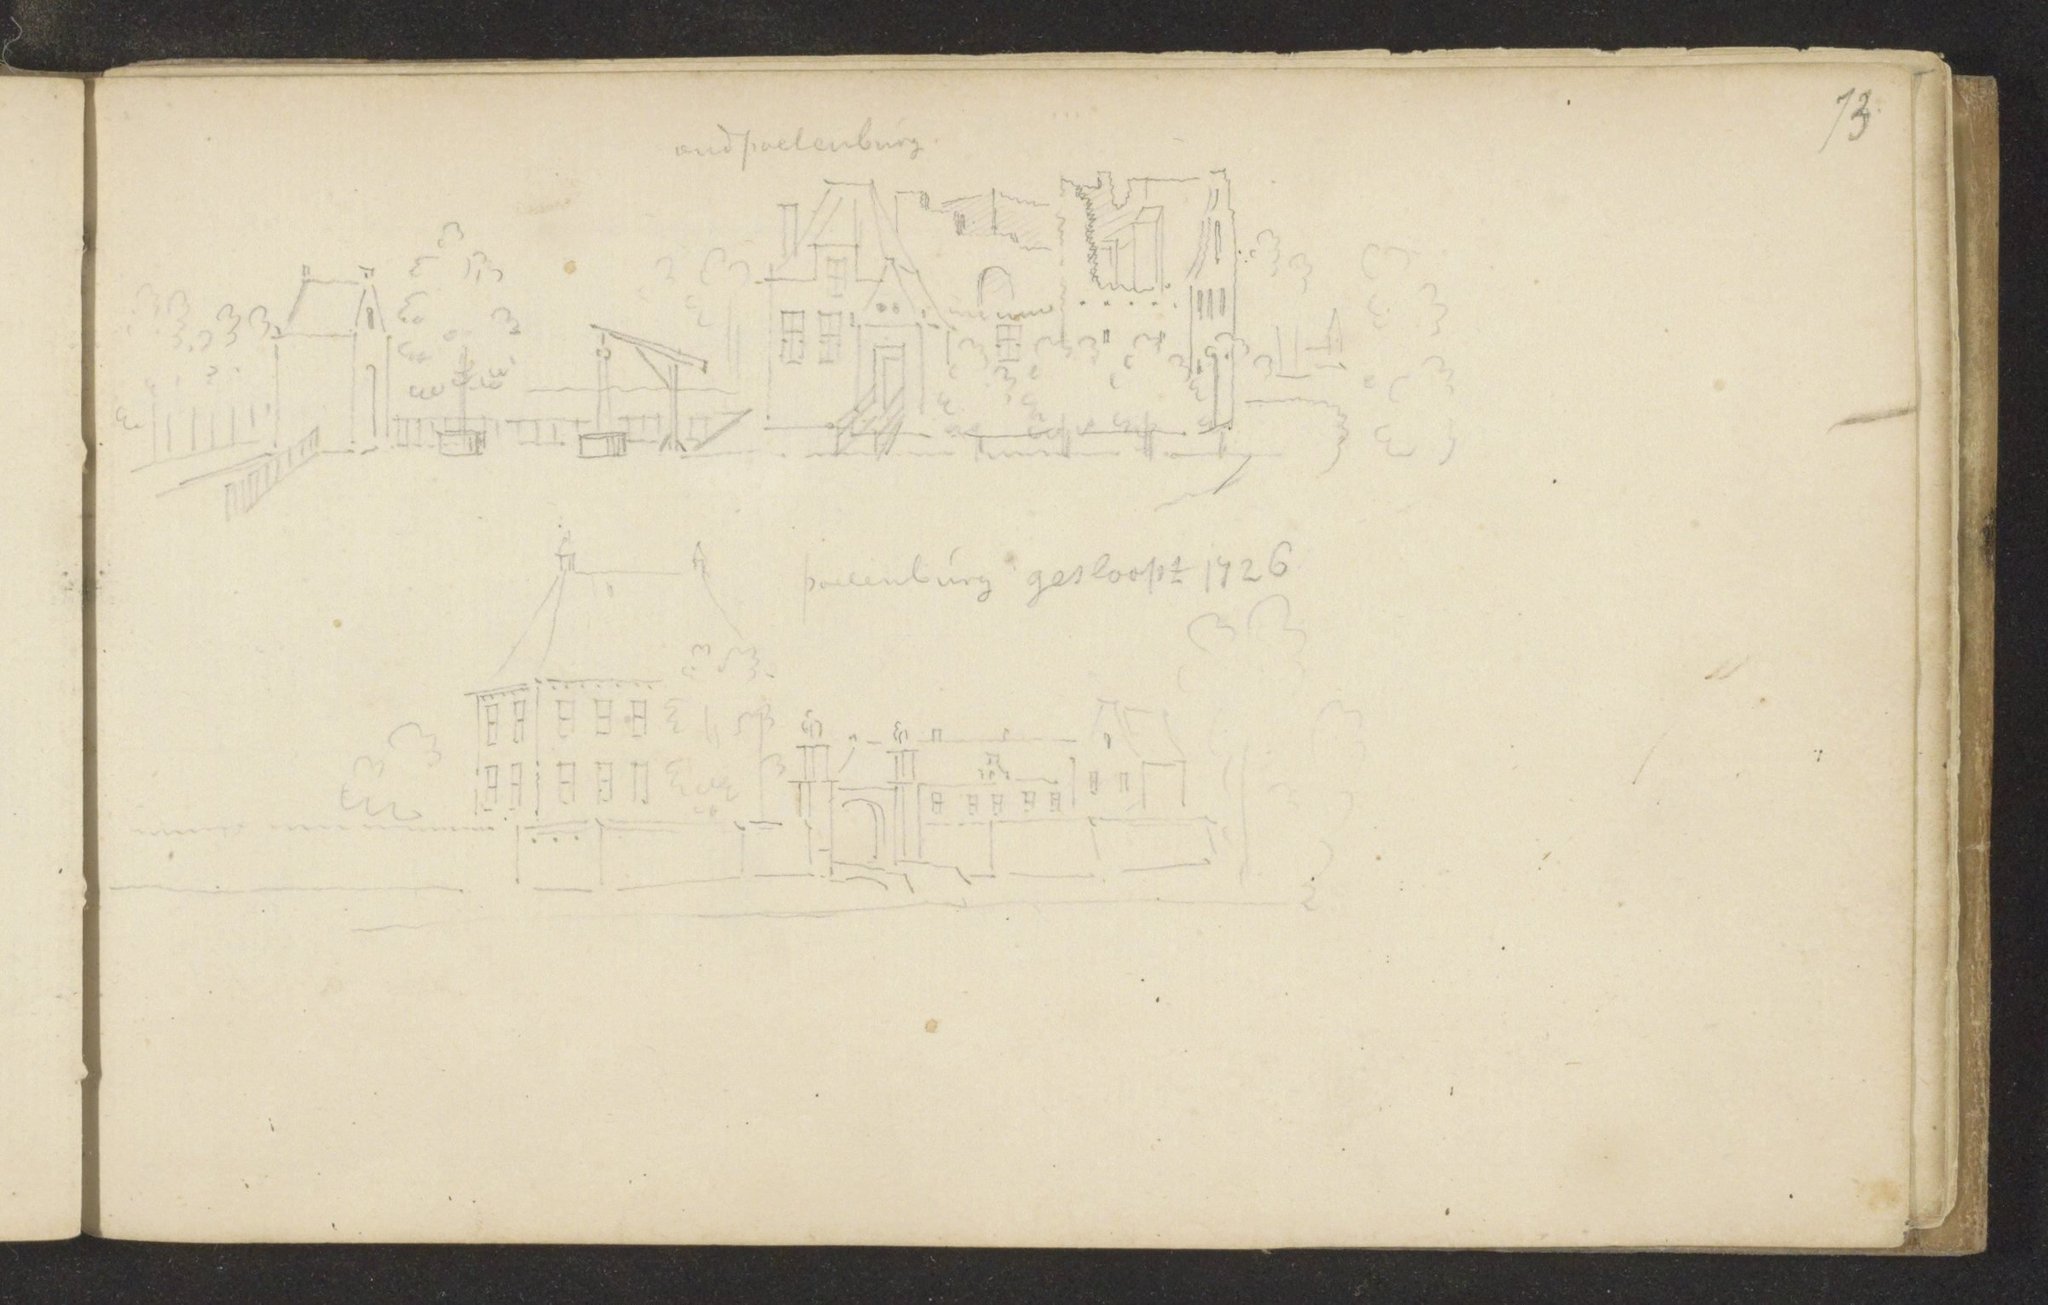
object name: sketchbook leaf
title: Gezichten op Huis Poelenburg bij Heemskerk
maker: abraham de haen (ii)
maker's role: draughtsman, print maker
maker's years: 1707-1748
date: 1731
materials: paper, pencil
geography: heemskerk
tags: ruin of a building ~ architecture, country-house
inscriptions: annotation: ‘oudpoelenburg/ poelenburg gesloopt 1726’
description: Blad 73 recto uit een schetsboek met 78 bladen.